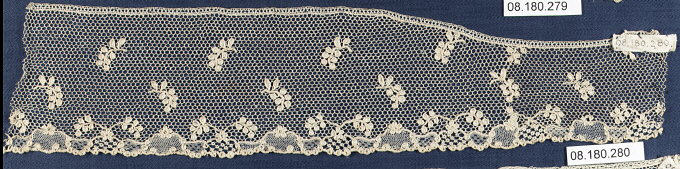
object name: fragment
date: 1701-1800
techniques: lace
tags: leaves